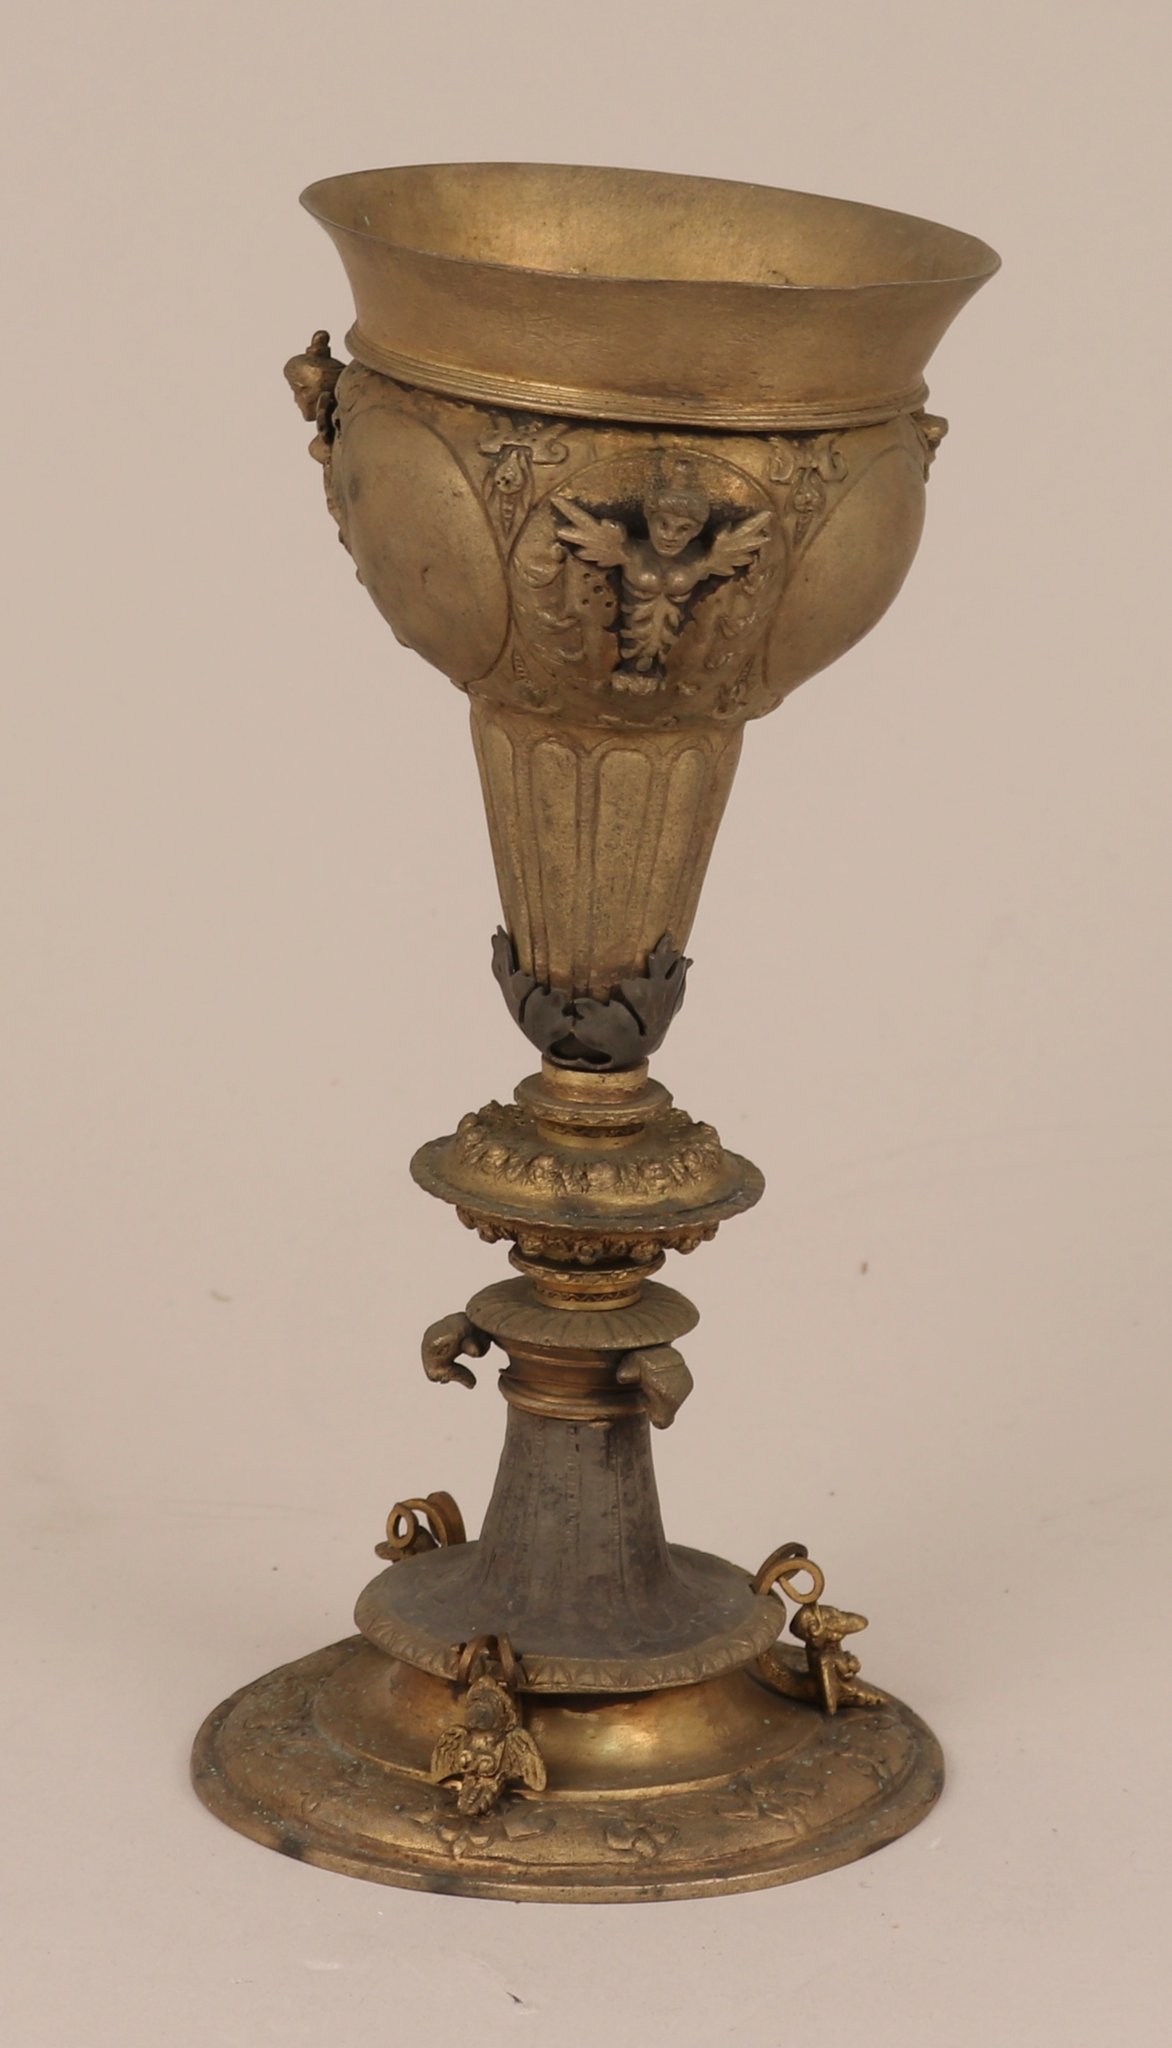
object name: goblet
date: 1801-1900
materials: gilt, metal, silver